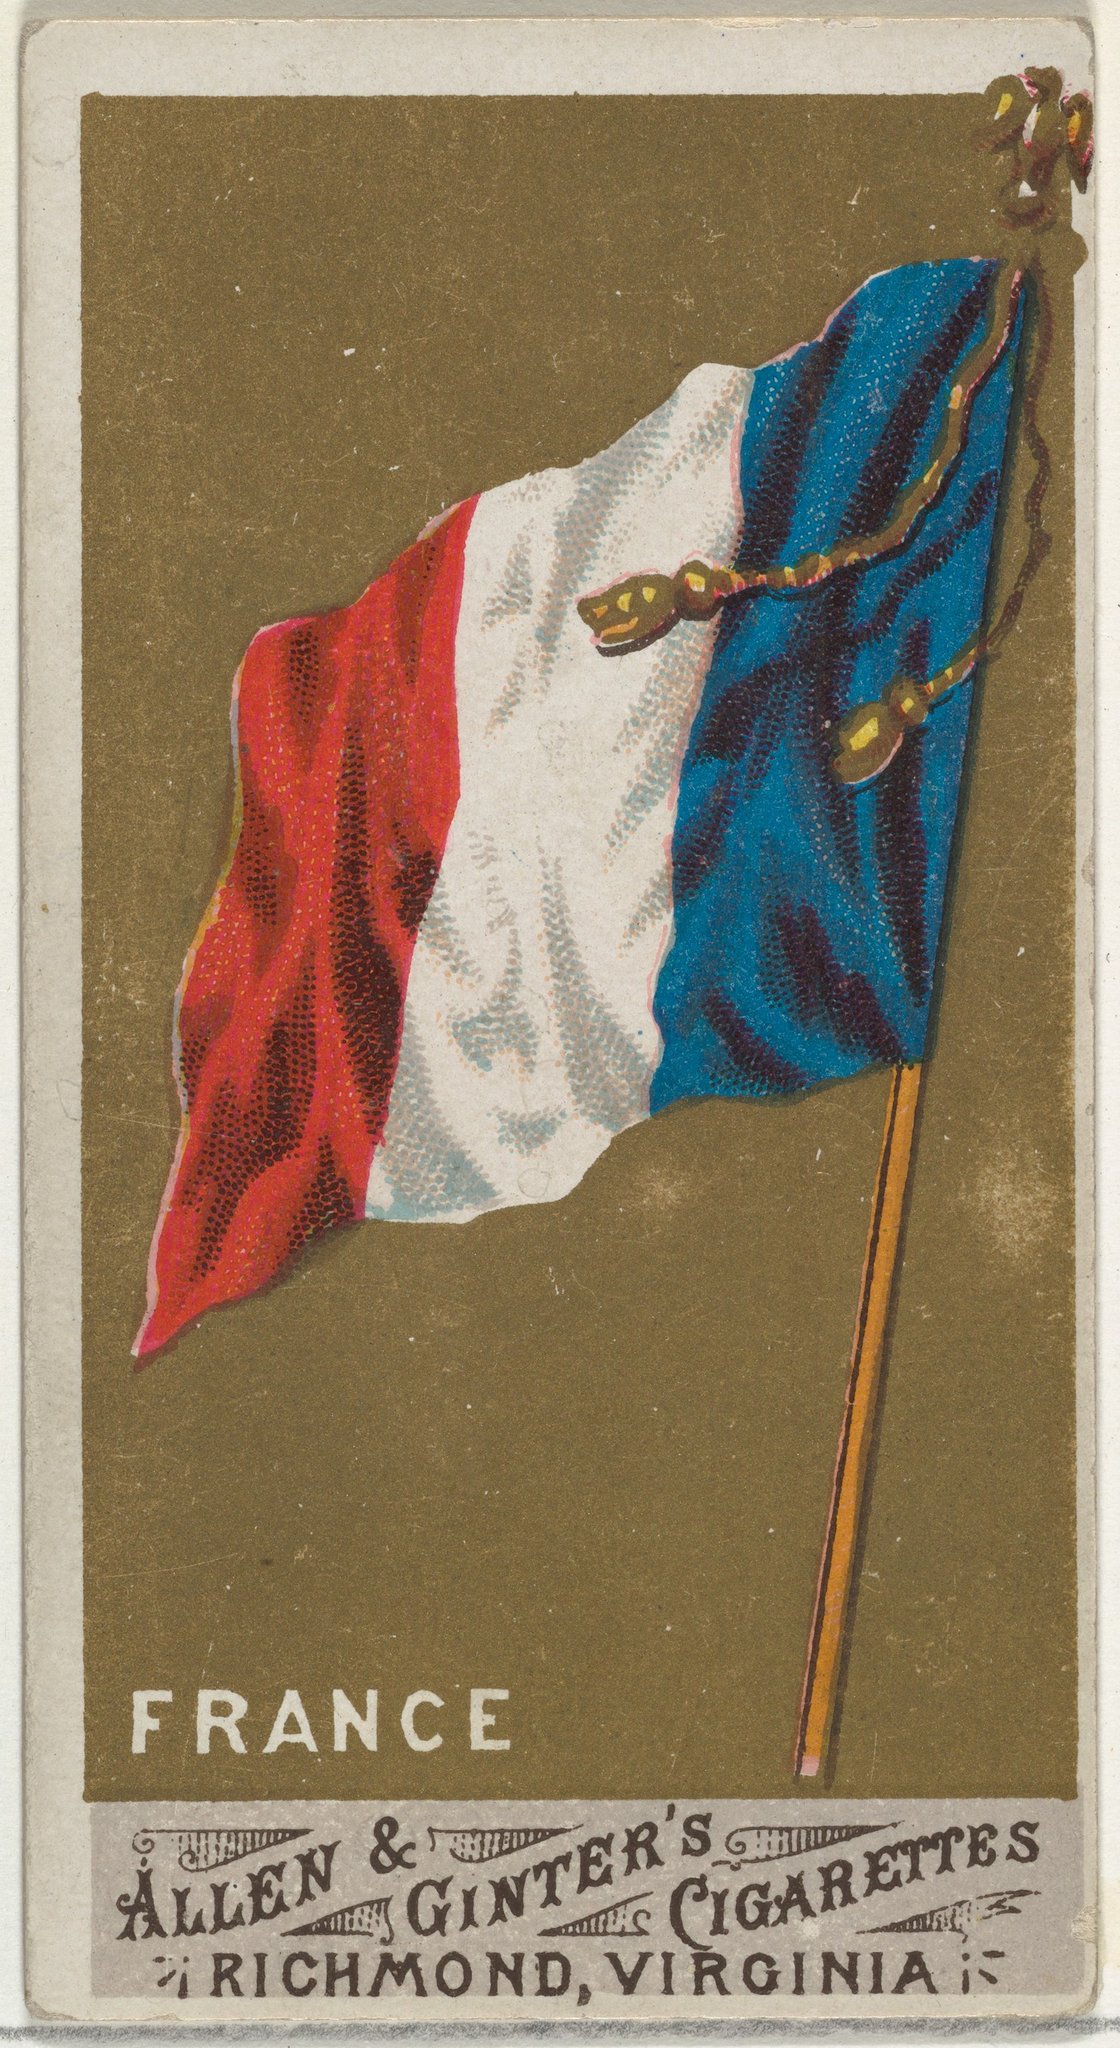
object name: print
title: France, from Flags of All Nations, Series 1 (N9) for Allen & Ginter Cigarettes Brands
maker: allen & ginter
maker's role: publisher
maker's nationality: american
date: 1887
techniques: color lithograph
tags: flags